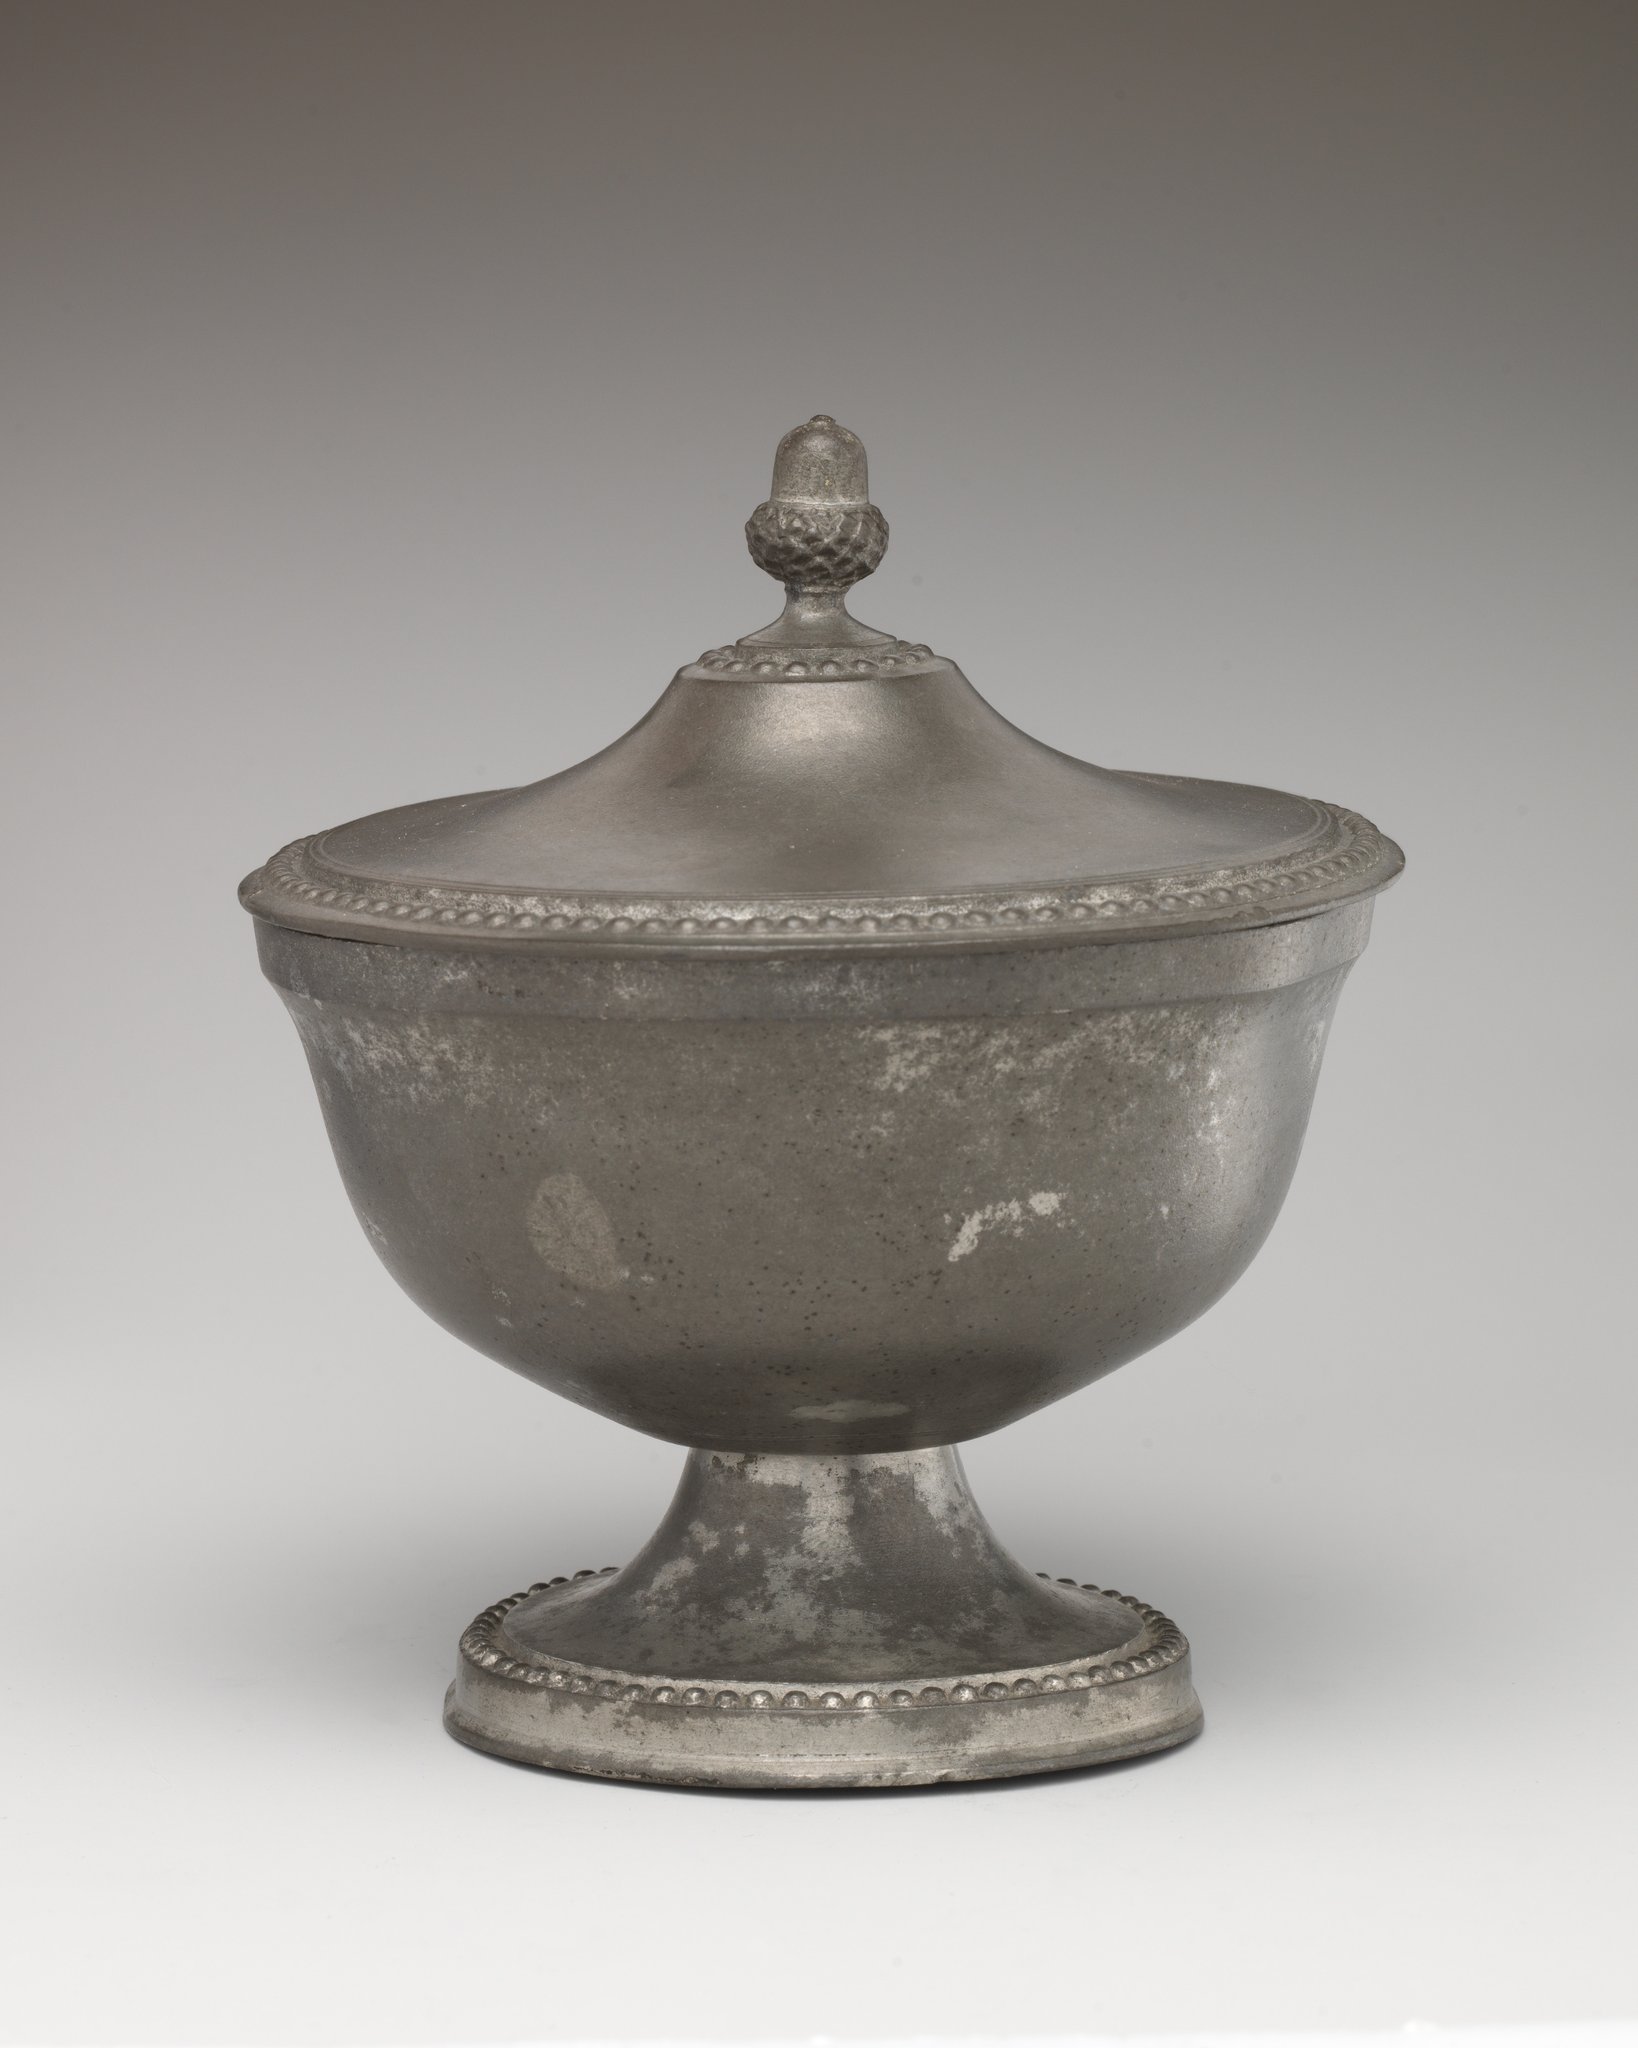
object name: bowl with cover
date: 1767-1800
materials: pewter